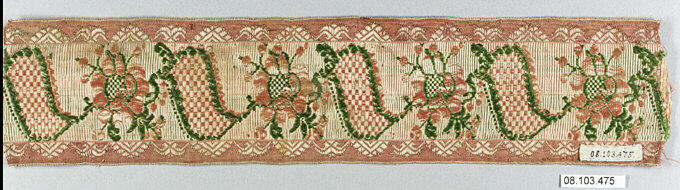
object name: galloon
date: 1801-1900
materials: silk